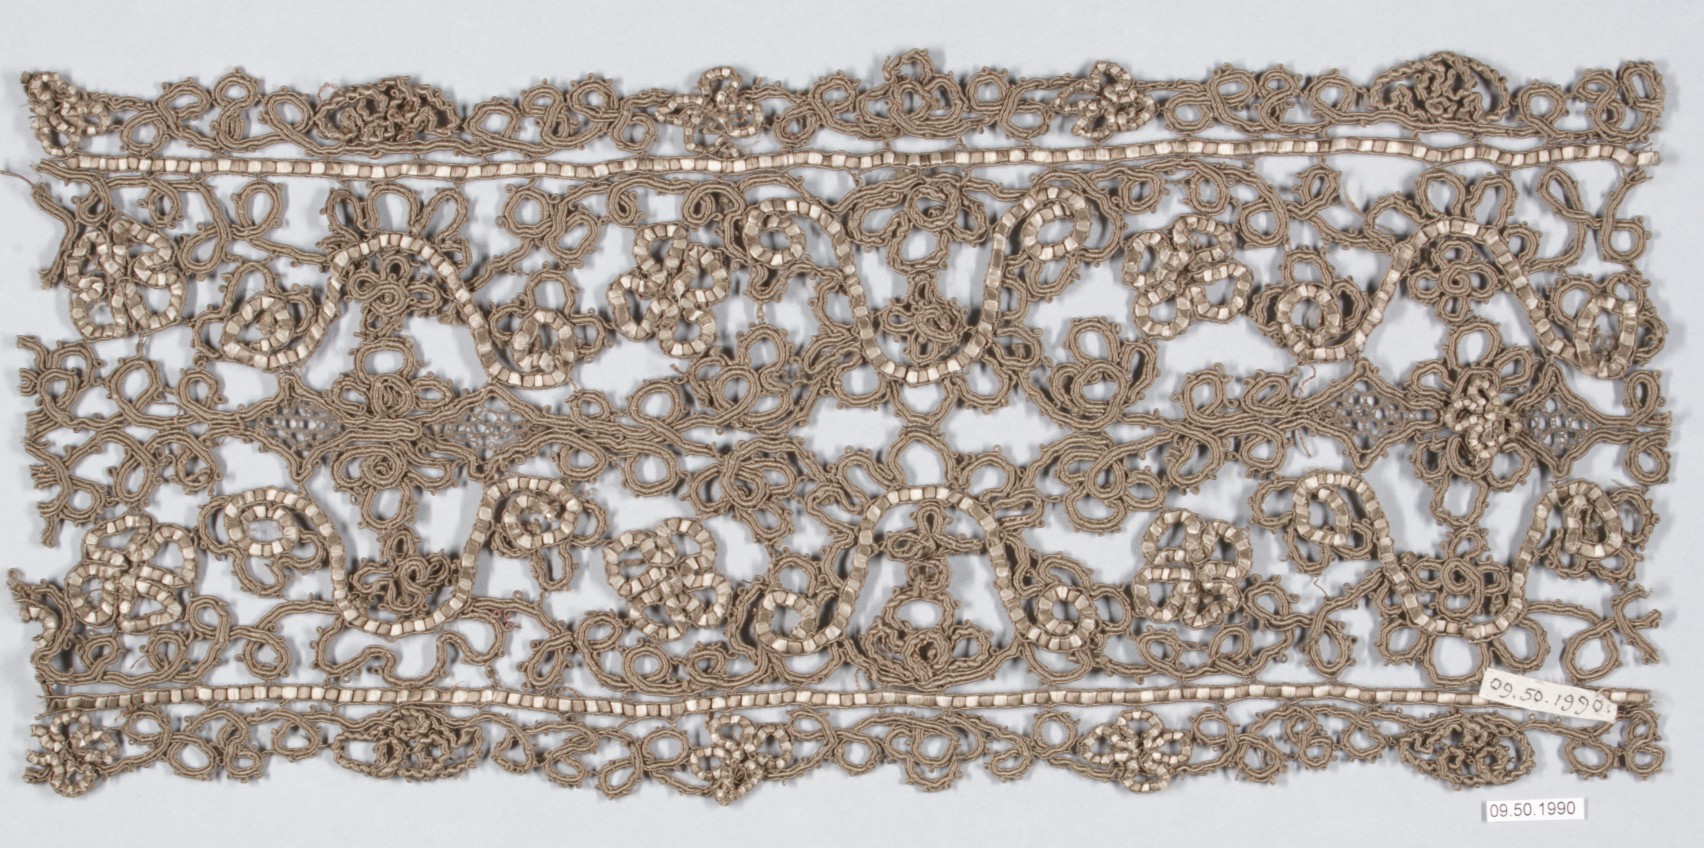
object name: passementerie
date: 1601-1700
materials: silk